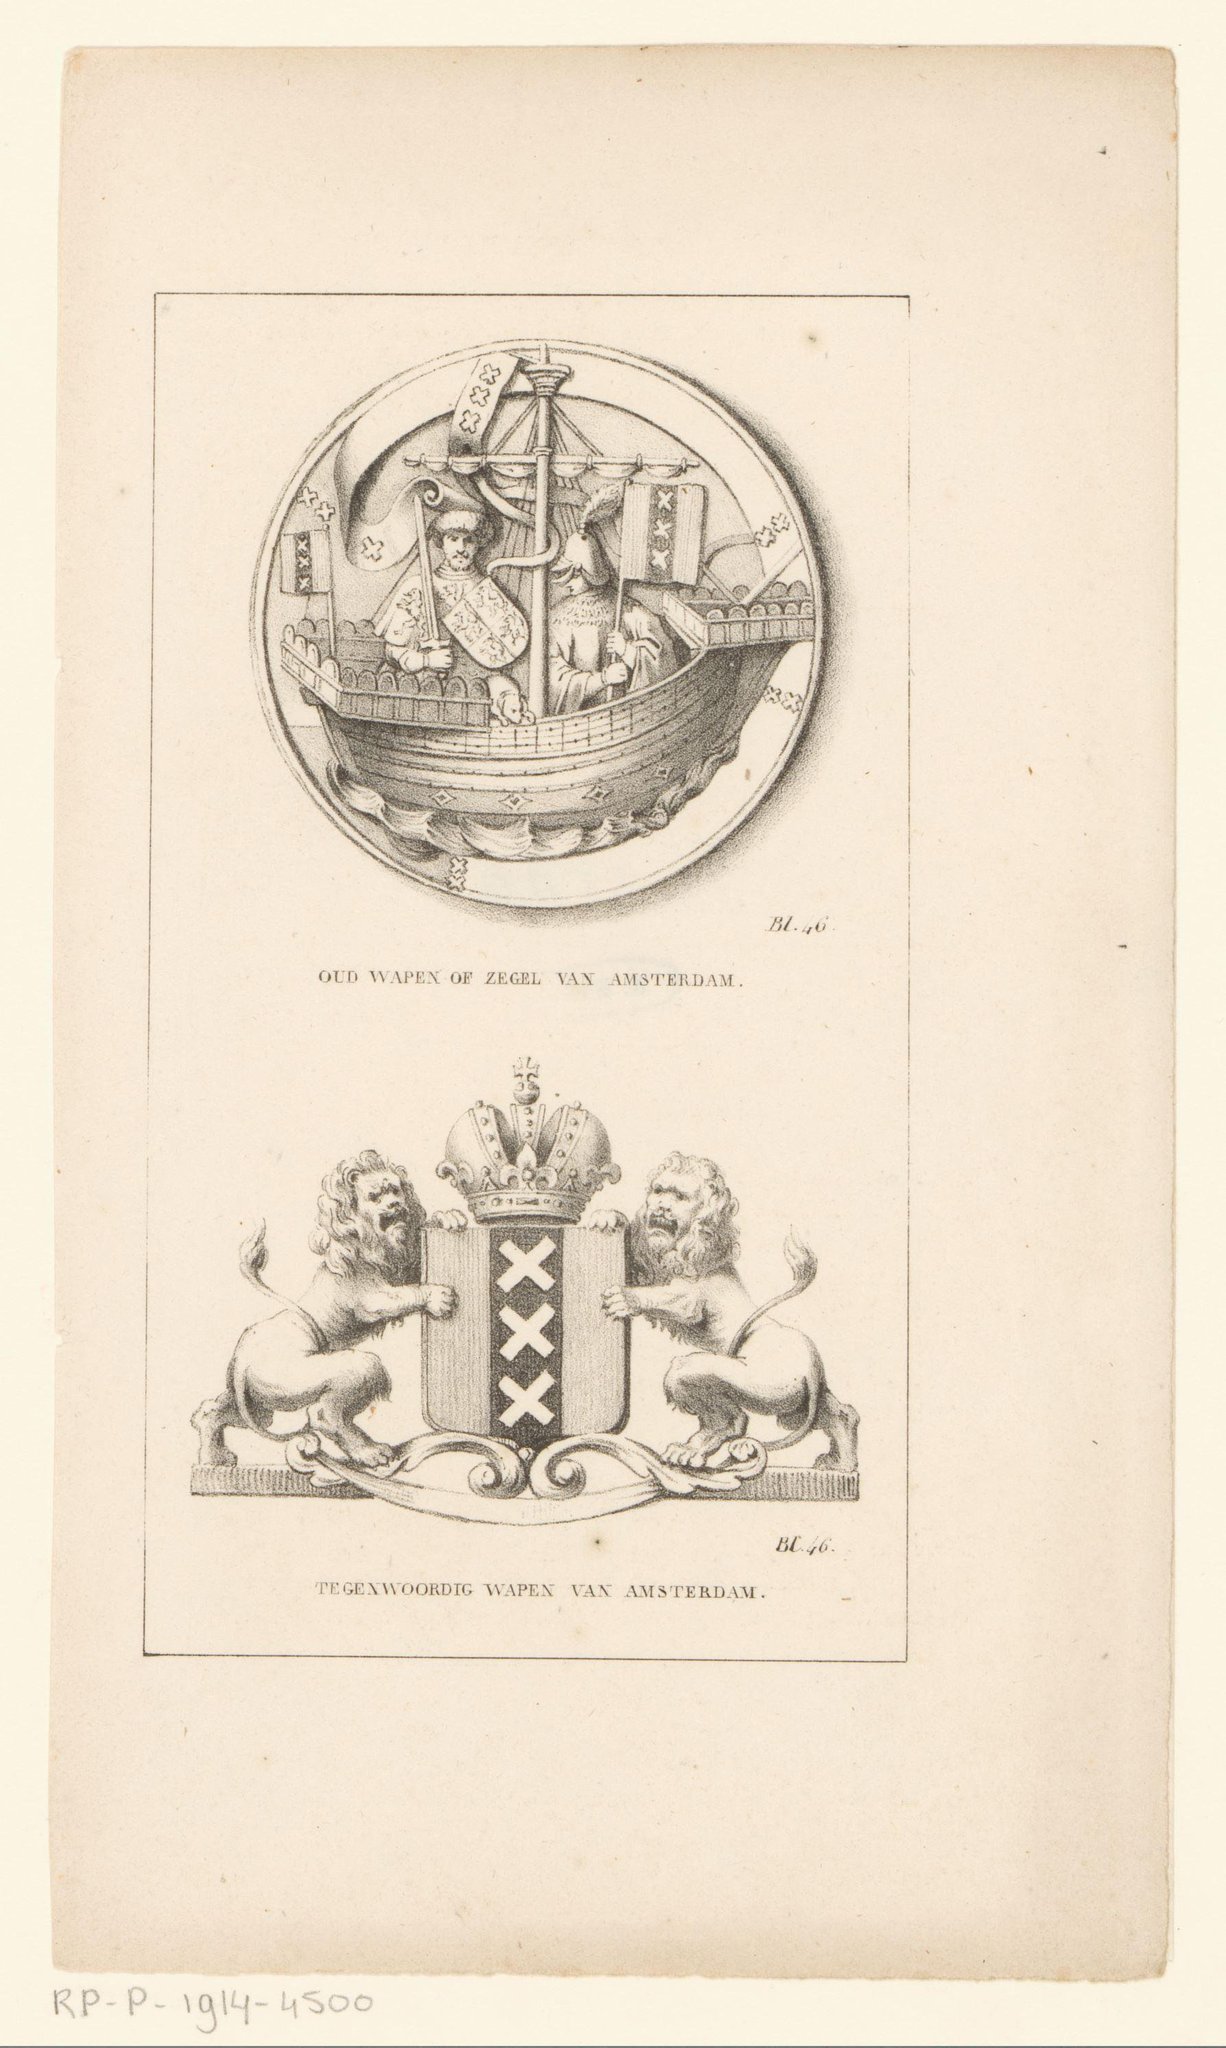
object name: book illustration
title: Oude en nieuwe wapen van Amsterdam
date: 1844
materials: paper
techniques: lithograph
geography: amsterdam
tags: coat of arms (as symbol of the state, etc.), amsterdam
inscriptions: collector's mark: Lugt 2228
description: Prent uit: Vijver, C. van der. Geschiedkundige beschrijving der stad Amsterdam. Amsterdam: Diederichs, Gebroeders, 1844.